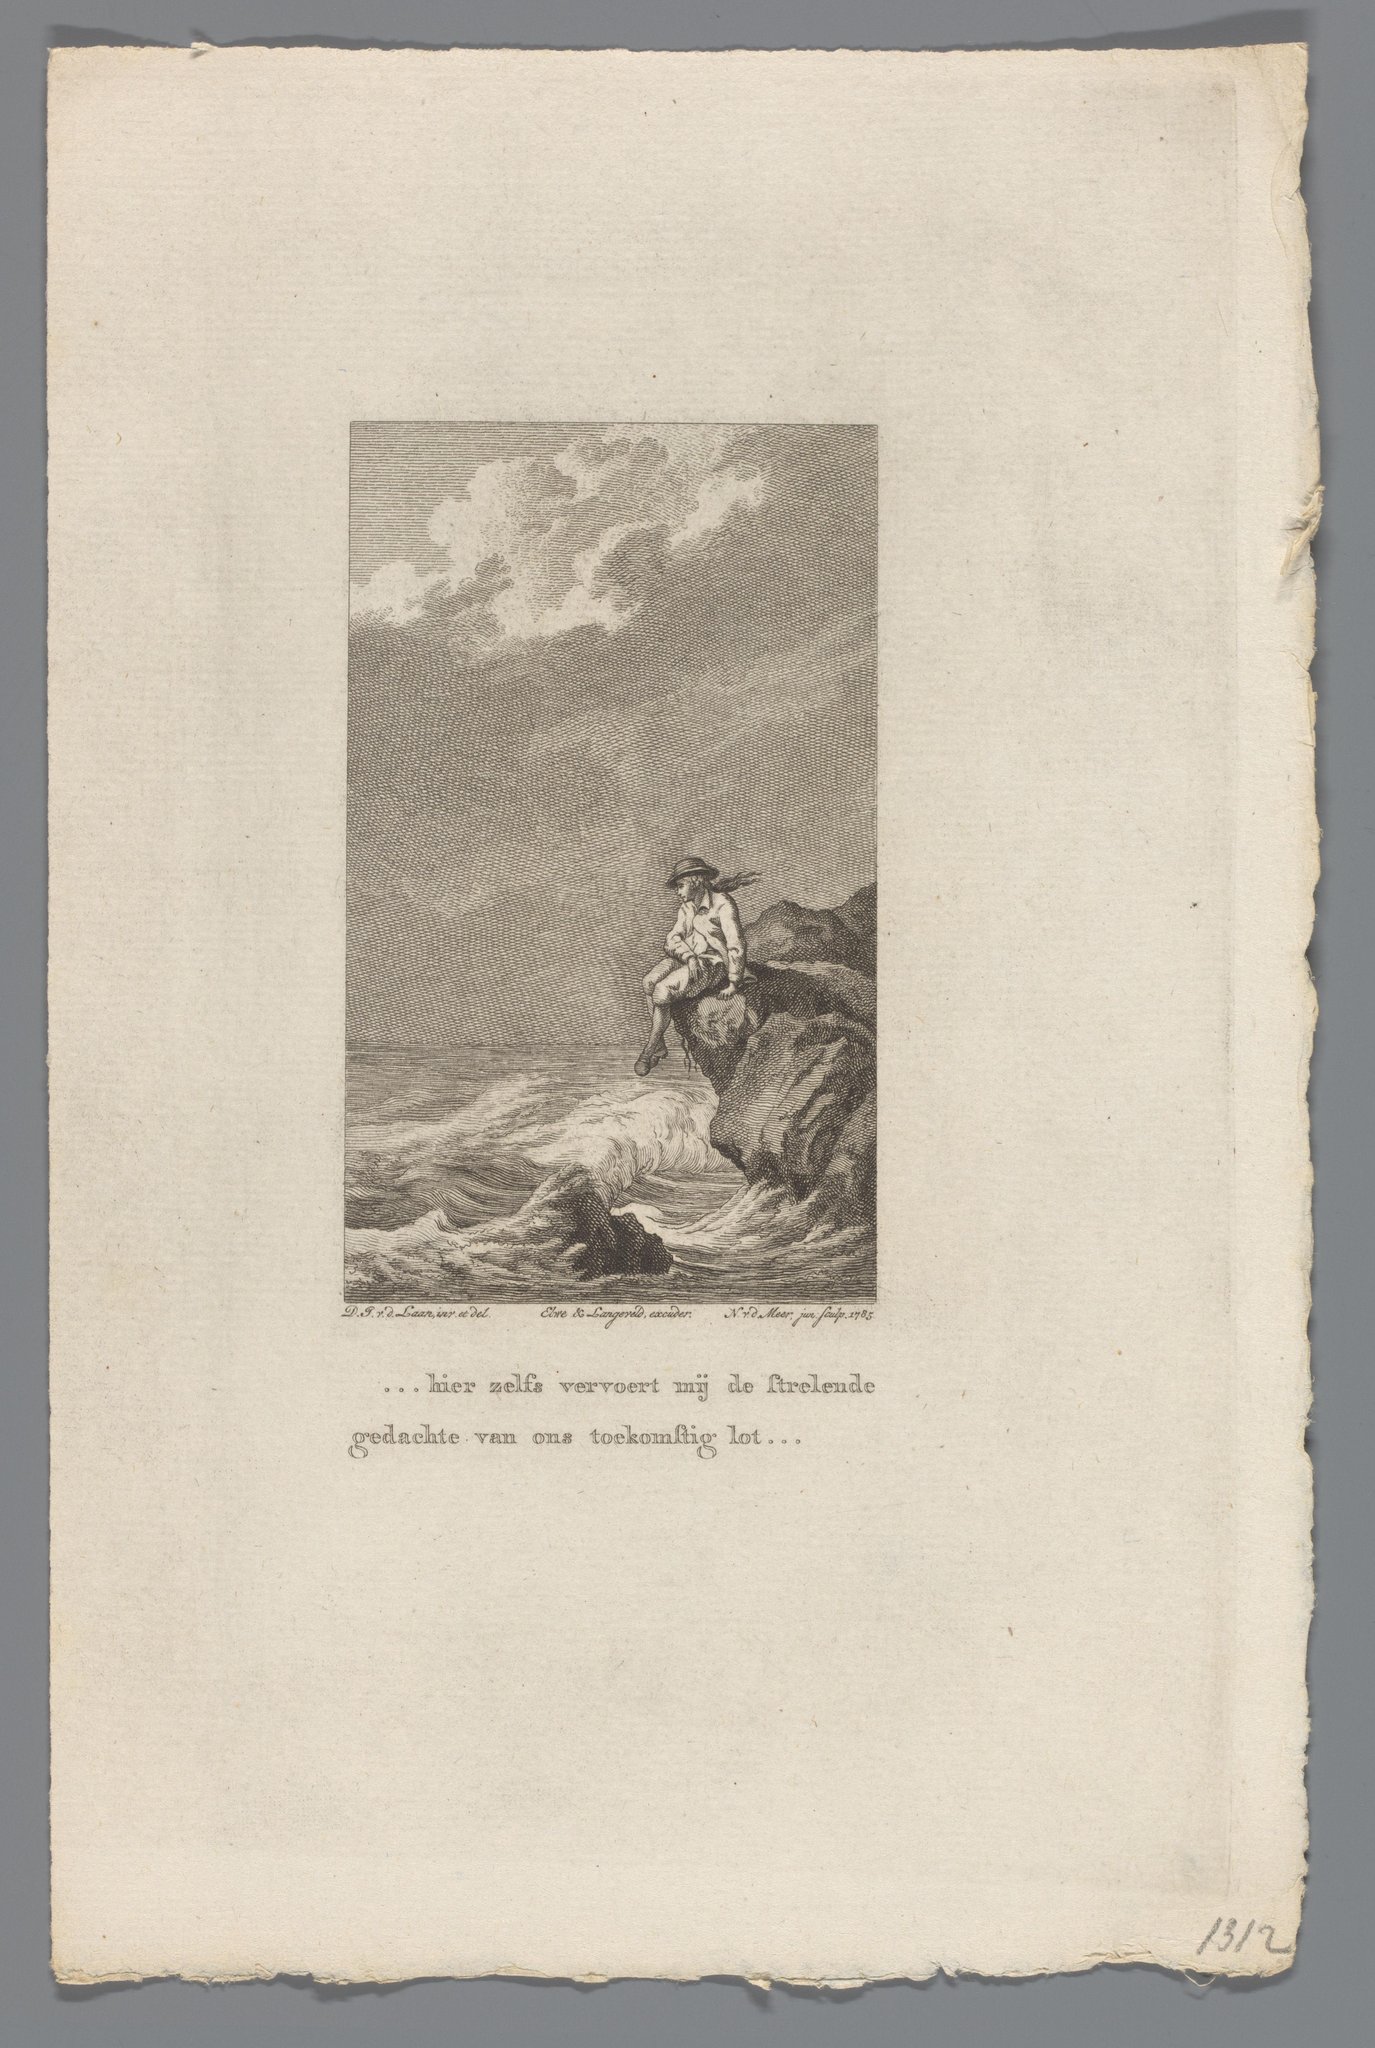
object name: print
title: Zittende man op een rots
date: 1785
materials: paper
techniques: etching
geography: amsterdam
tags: rocks, sea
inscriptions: collector's mark: Lugt 2228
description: Prent bij: Feith, Rhĳnvis. Julia. Amsterdam, Jan Barend Elwe and Dirk Meland Langeveld, 1786.